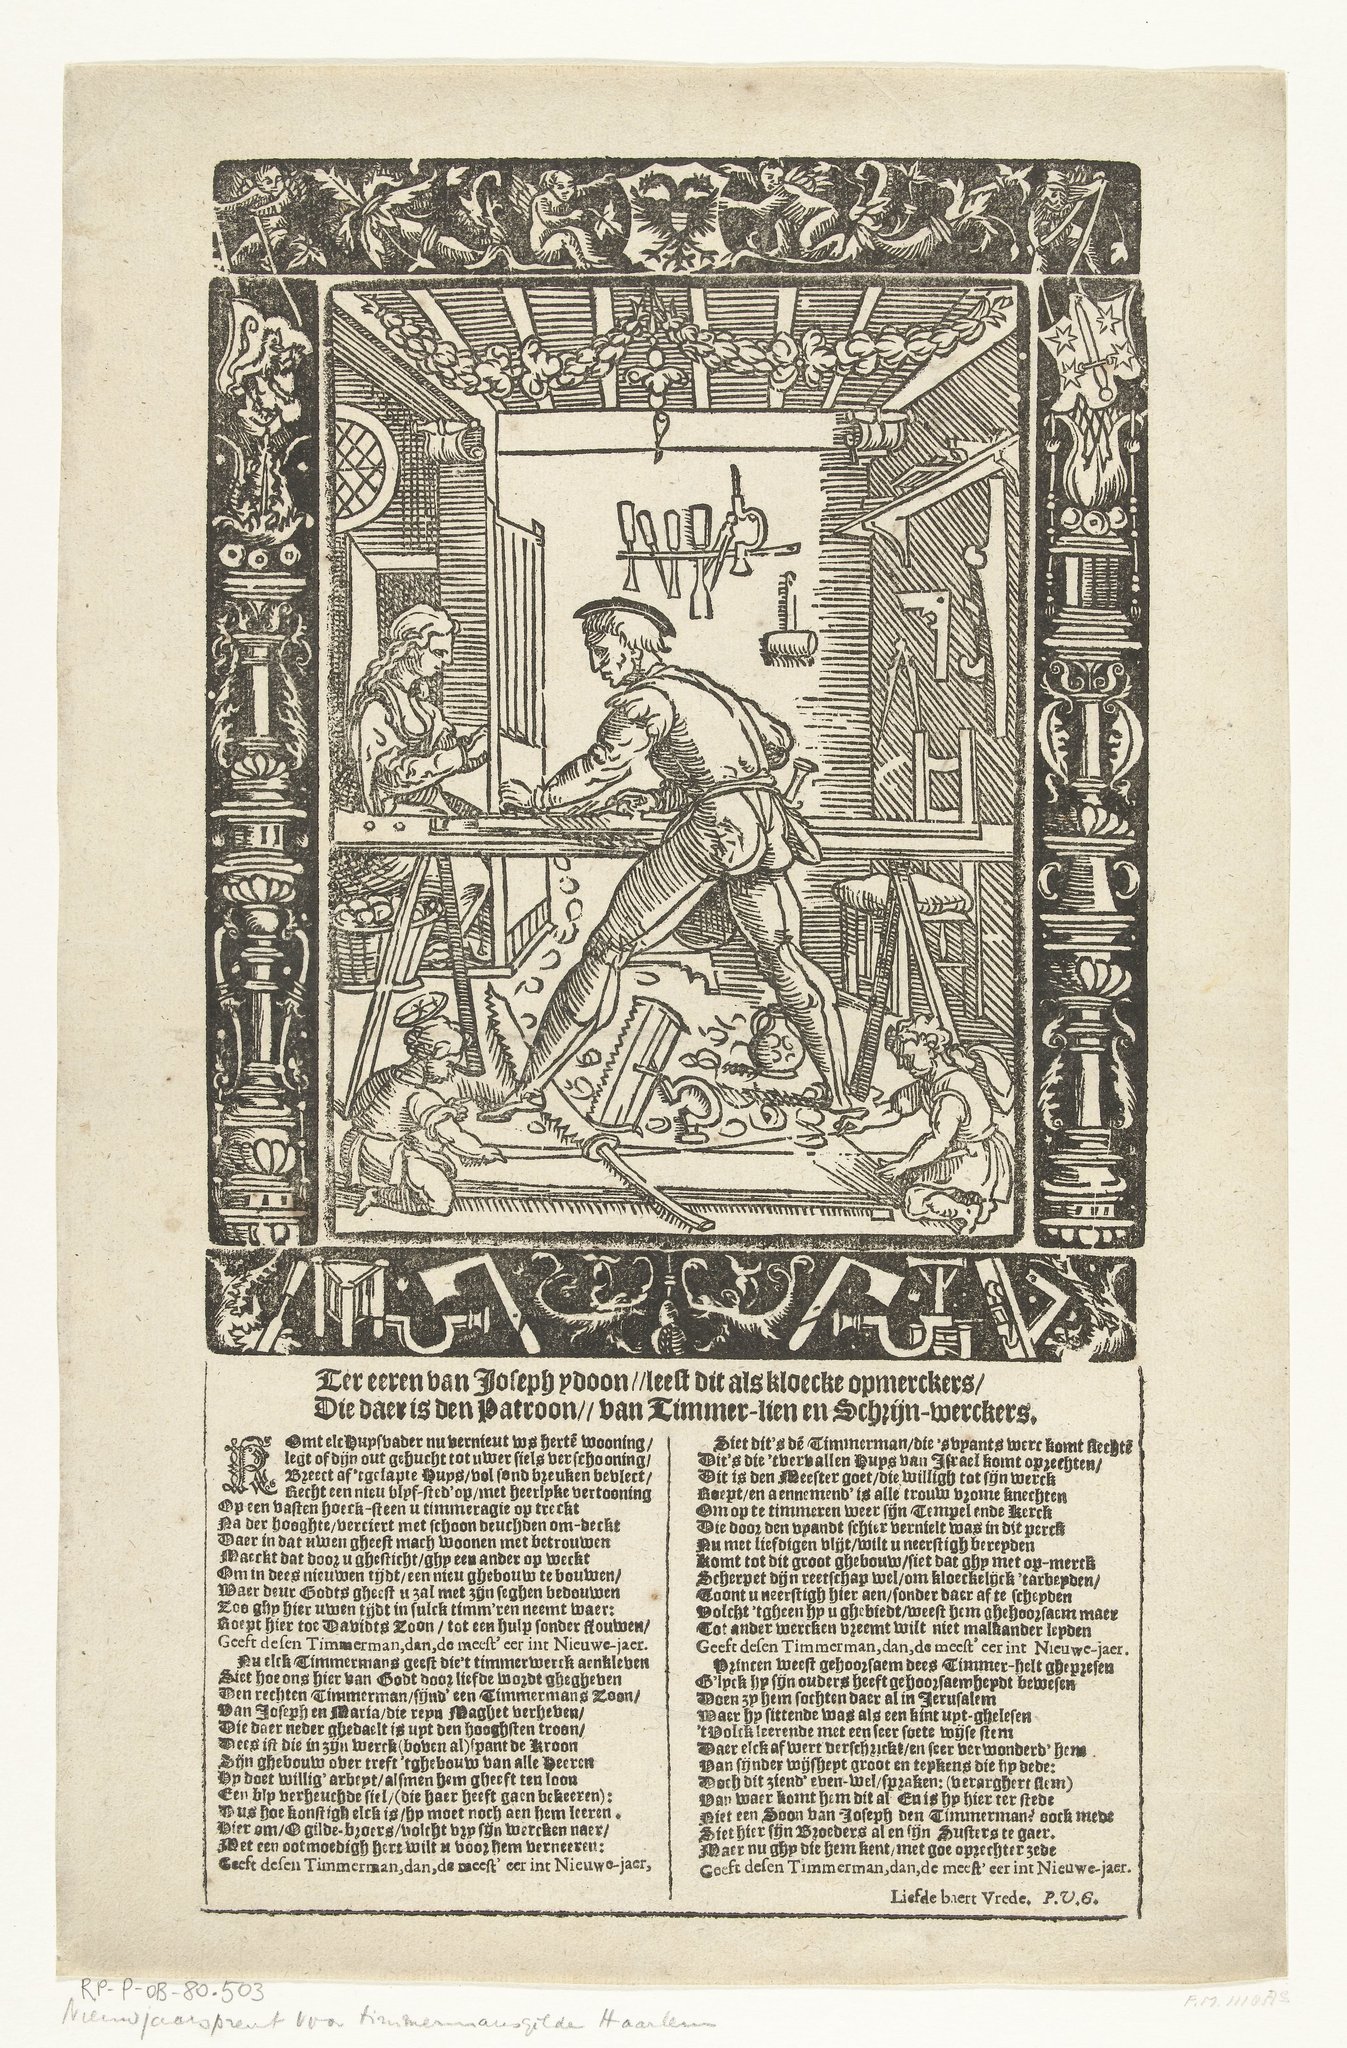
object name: new year card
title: Nieuwjaarsprent van het timmermansgilde te Haarlem, ca. 1600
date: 1590-1610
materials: paper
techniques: letterpress printing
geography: haarlem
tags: carpenter, joseph at work in his carpenter's workshop, joseph with the christ-child (and mary) in his carpenter's workshop, haarlem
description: Nieuwjaarsprent van het timmermansgilde of Sint-Jozefsgilde te Haarlem, ca. 1600. Jozef aan het werk in zijn timmerwerkplaats, op de vloer spelen het Christuskind en Johannes de Doper, links Maria. Voorstelling in omlijsting met putti met de wapens van Habsburg en Haarlem, attributen van de timmerman en ornamenten. Onderaan de nieuwjaarsgroet in 4 verzen van elk 13 regels in 2 kolommen, getekend met het devies Liefde baert Vrede.